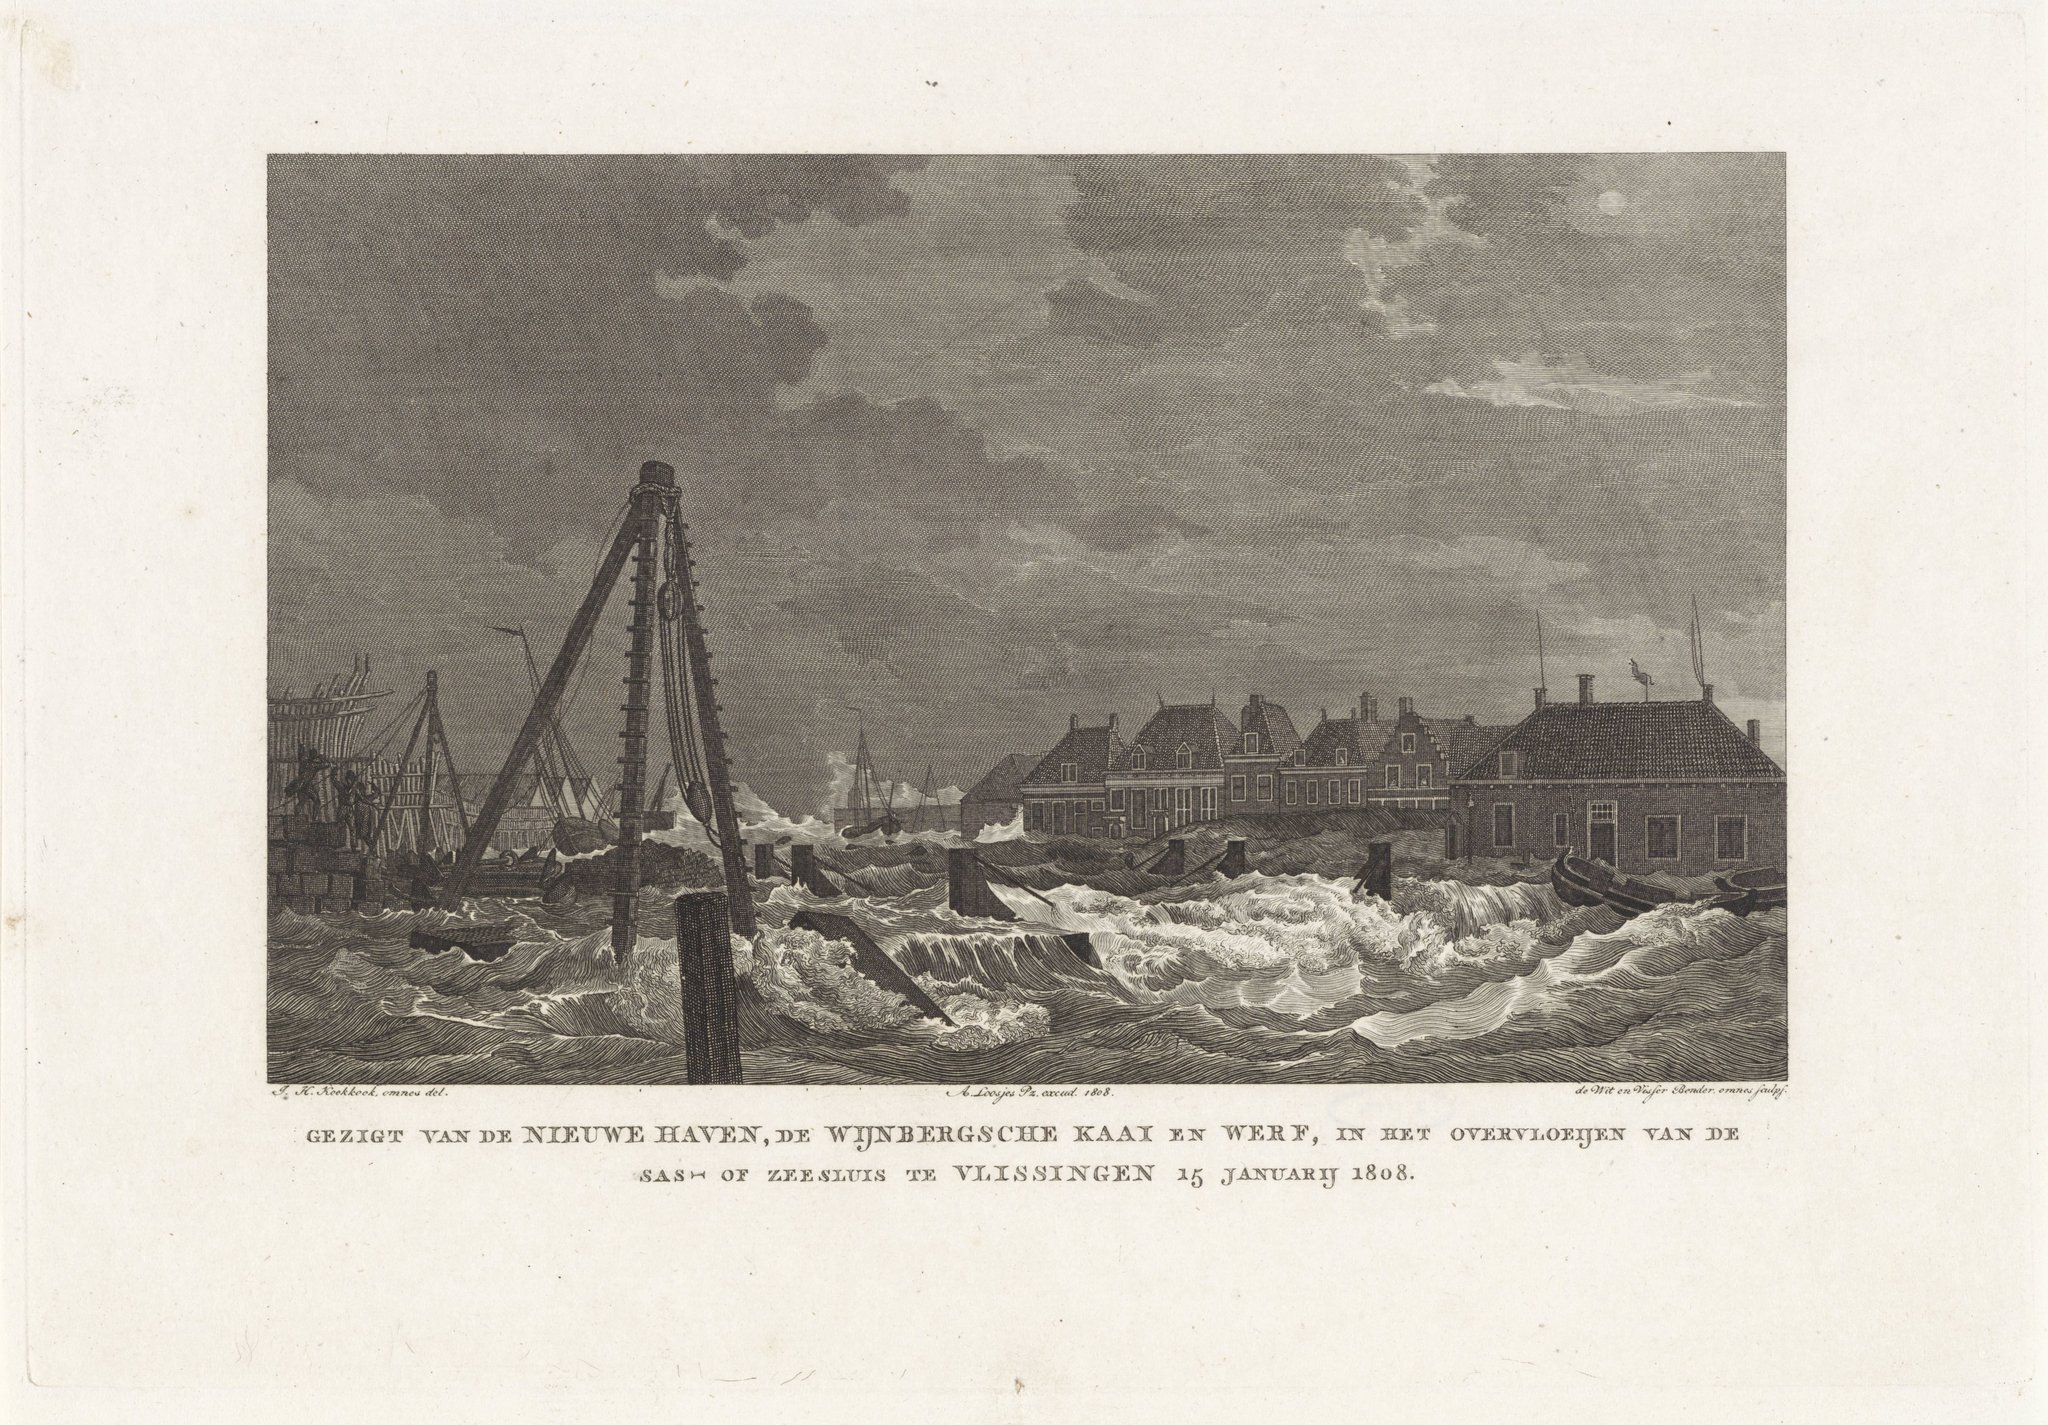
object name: print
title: Gezigt van de Nieuwe Haven, de Wijnbergse Kaai en Wef, in het overvloeijen van de Sas- of Zeesluis te Vlissingen 15 januarij 1808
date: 1808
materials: paper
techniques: etching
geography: haarlem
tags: flood, flushing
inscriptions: collector's mark: Lugt Lugt 2228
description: Prent gebruikt in: Hoek, S. van. Natuur- en geschiedkundige beschrijving van den verschrikkelijken watervloed tusschen den XIVden en XVden van Louwmaand des jaars 1808. Haarlem: Adriaan Pietersz. Loosjes, 1808.